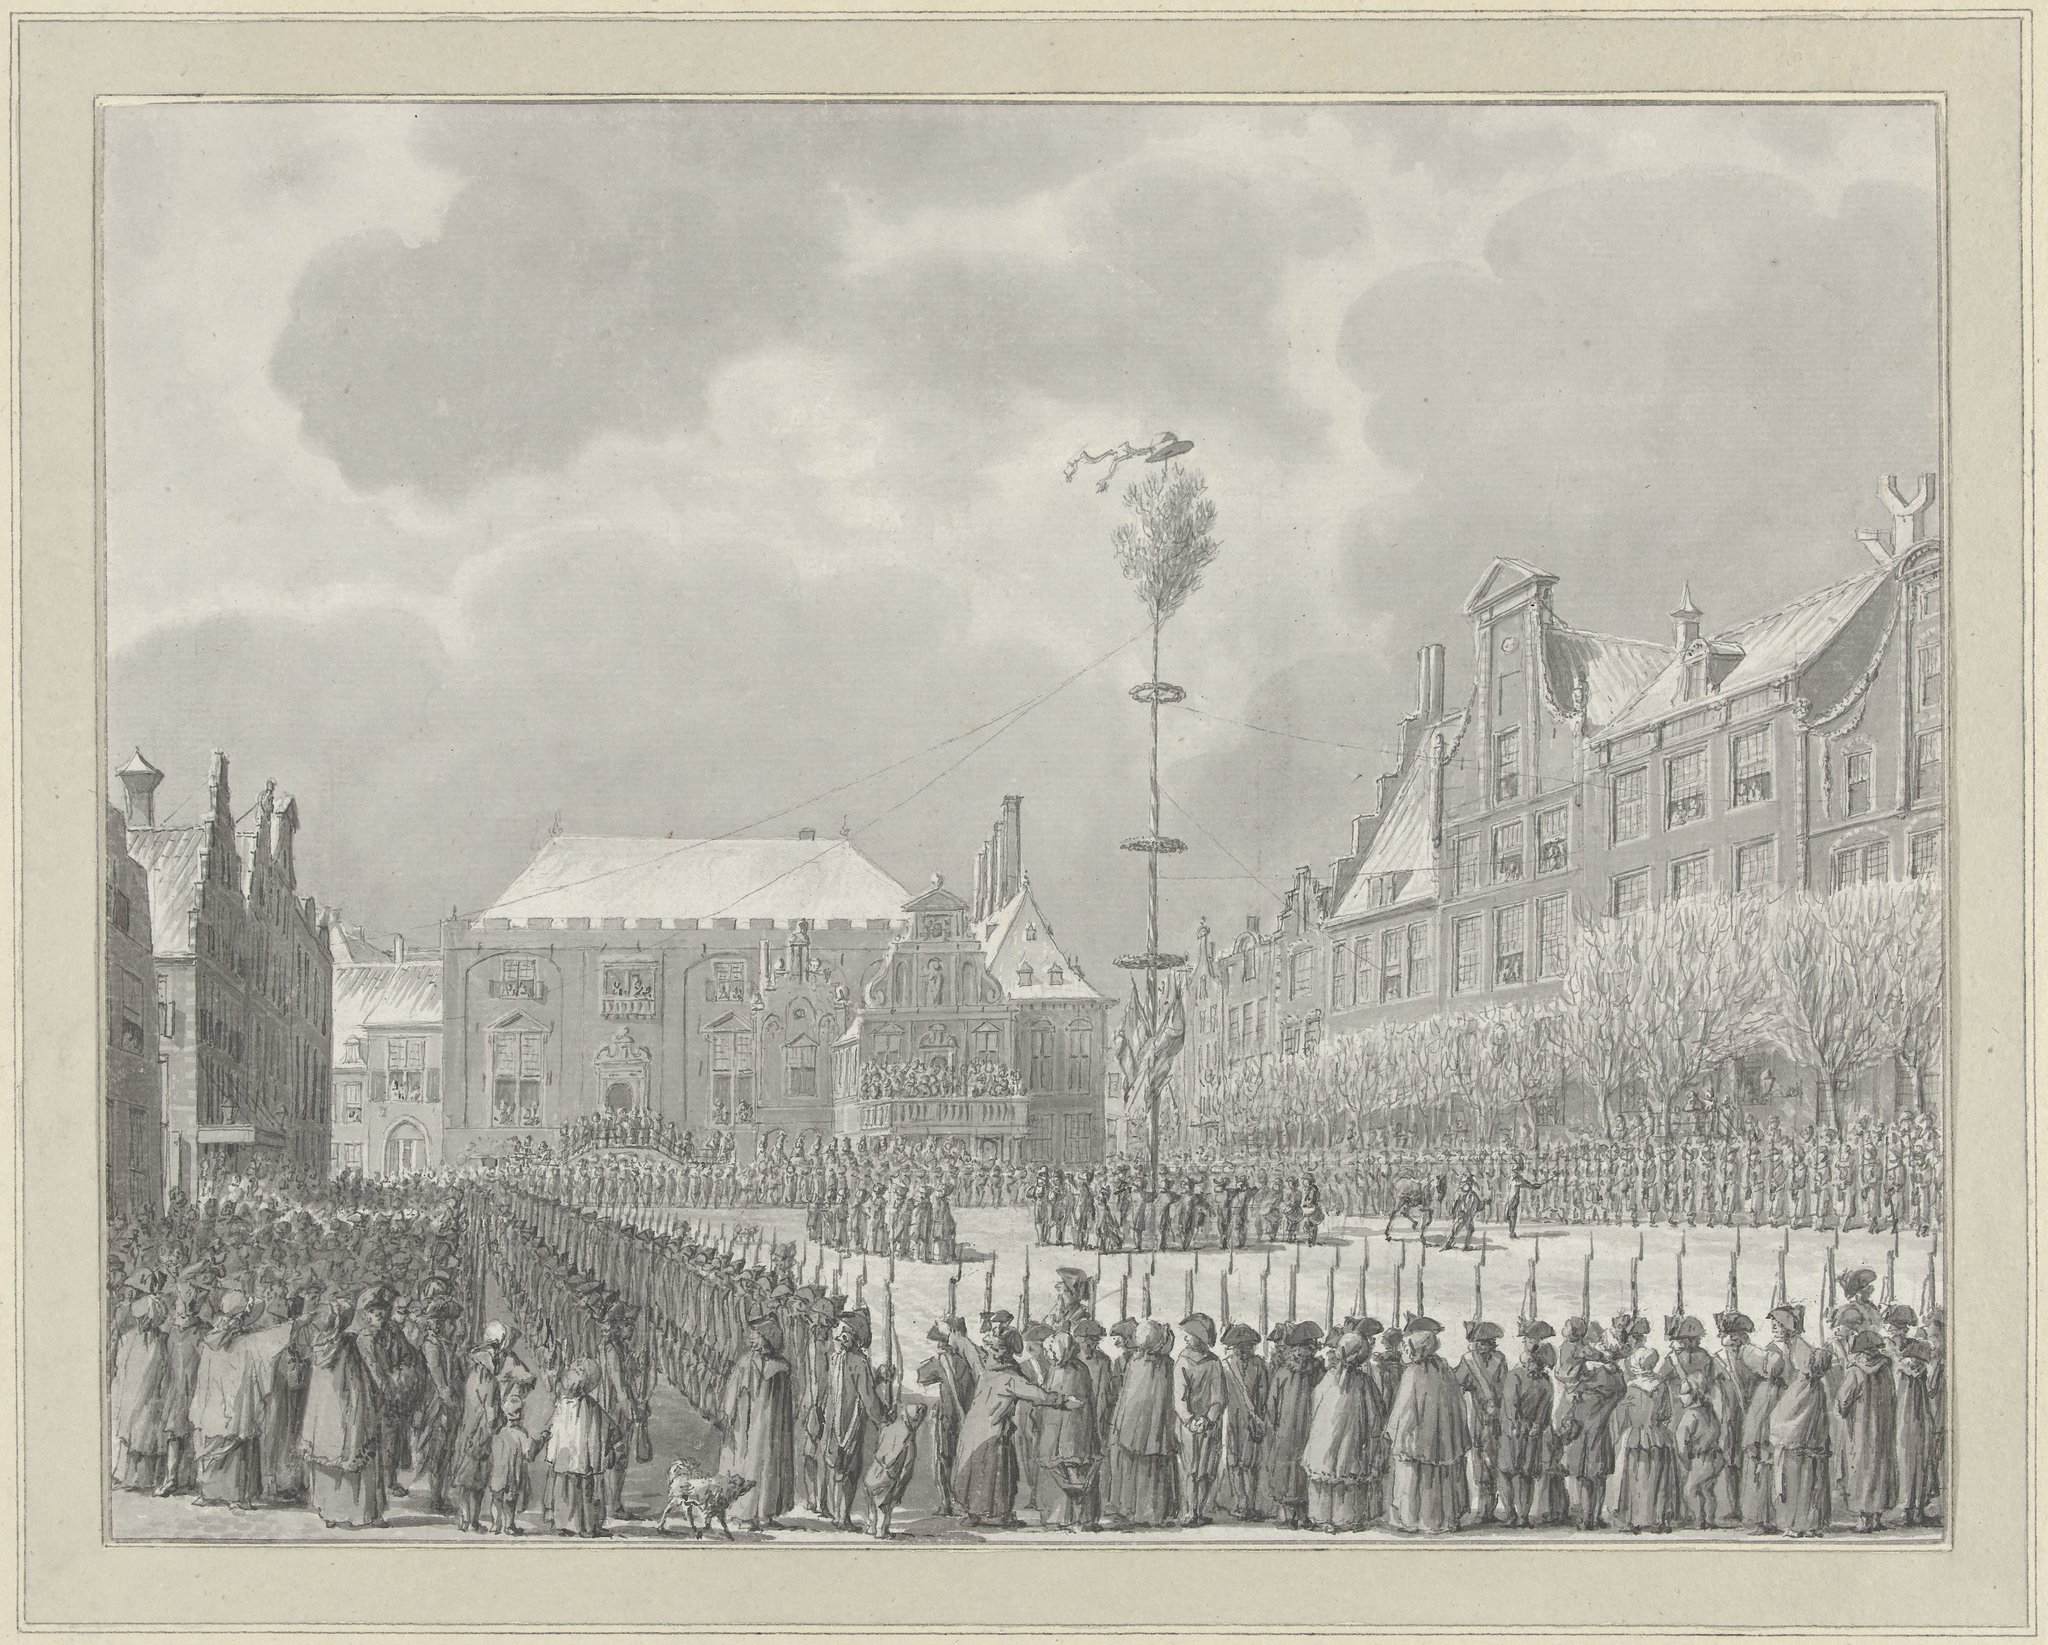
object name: drawing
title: Afschaffing van het Stadhouderschap op de Grote Markt te Haarlem, 1795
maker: vincent jansz. van der vinne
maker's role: draughtsman, print maker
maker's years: 1736-1811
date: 1795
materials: paper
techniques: brush, pen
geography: haarlem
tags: proclamation of new government, townhall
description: De proclamatie van de afschaffing van het Stadhouderschap op de Grote Markt te Haarlem, 6 februari 1795. Gezien naar het stadhuis; centraal op de markt een vrijheidsboom, rondom de markt staan rijen soldaten opgesteld.